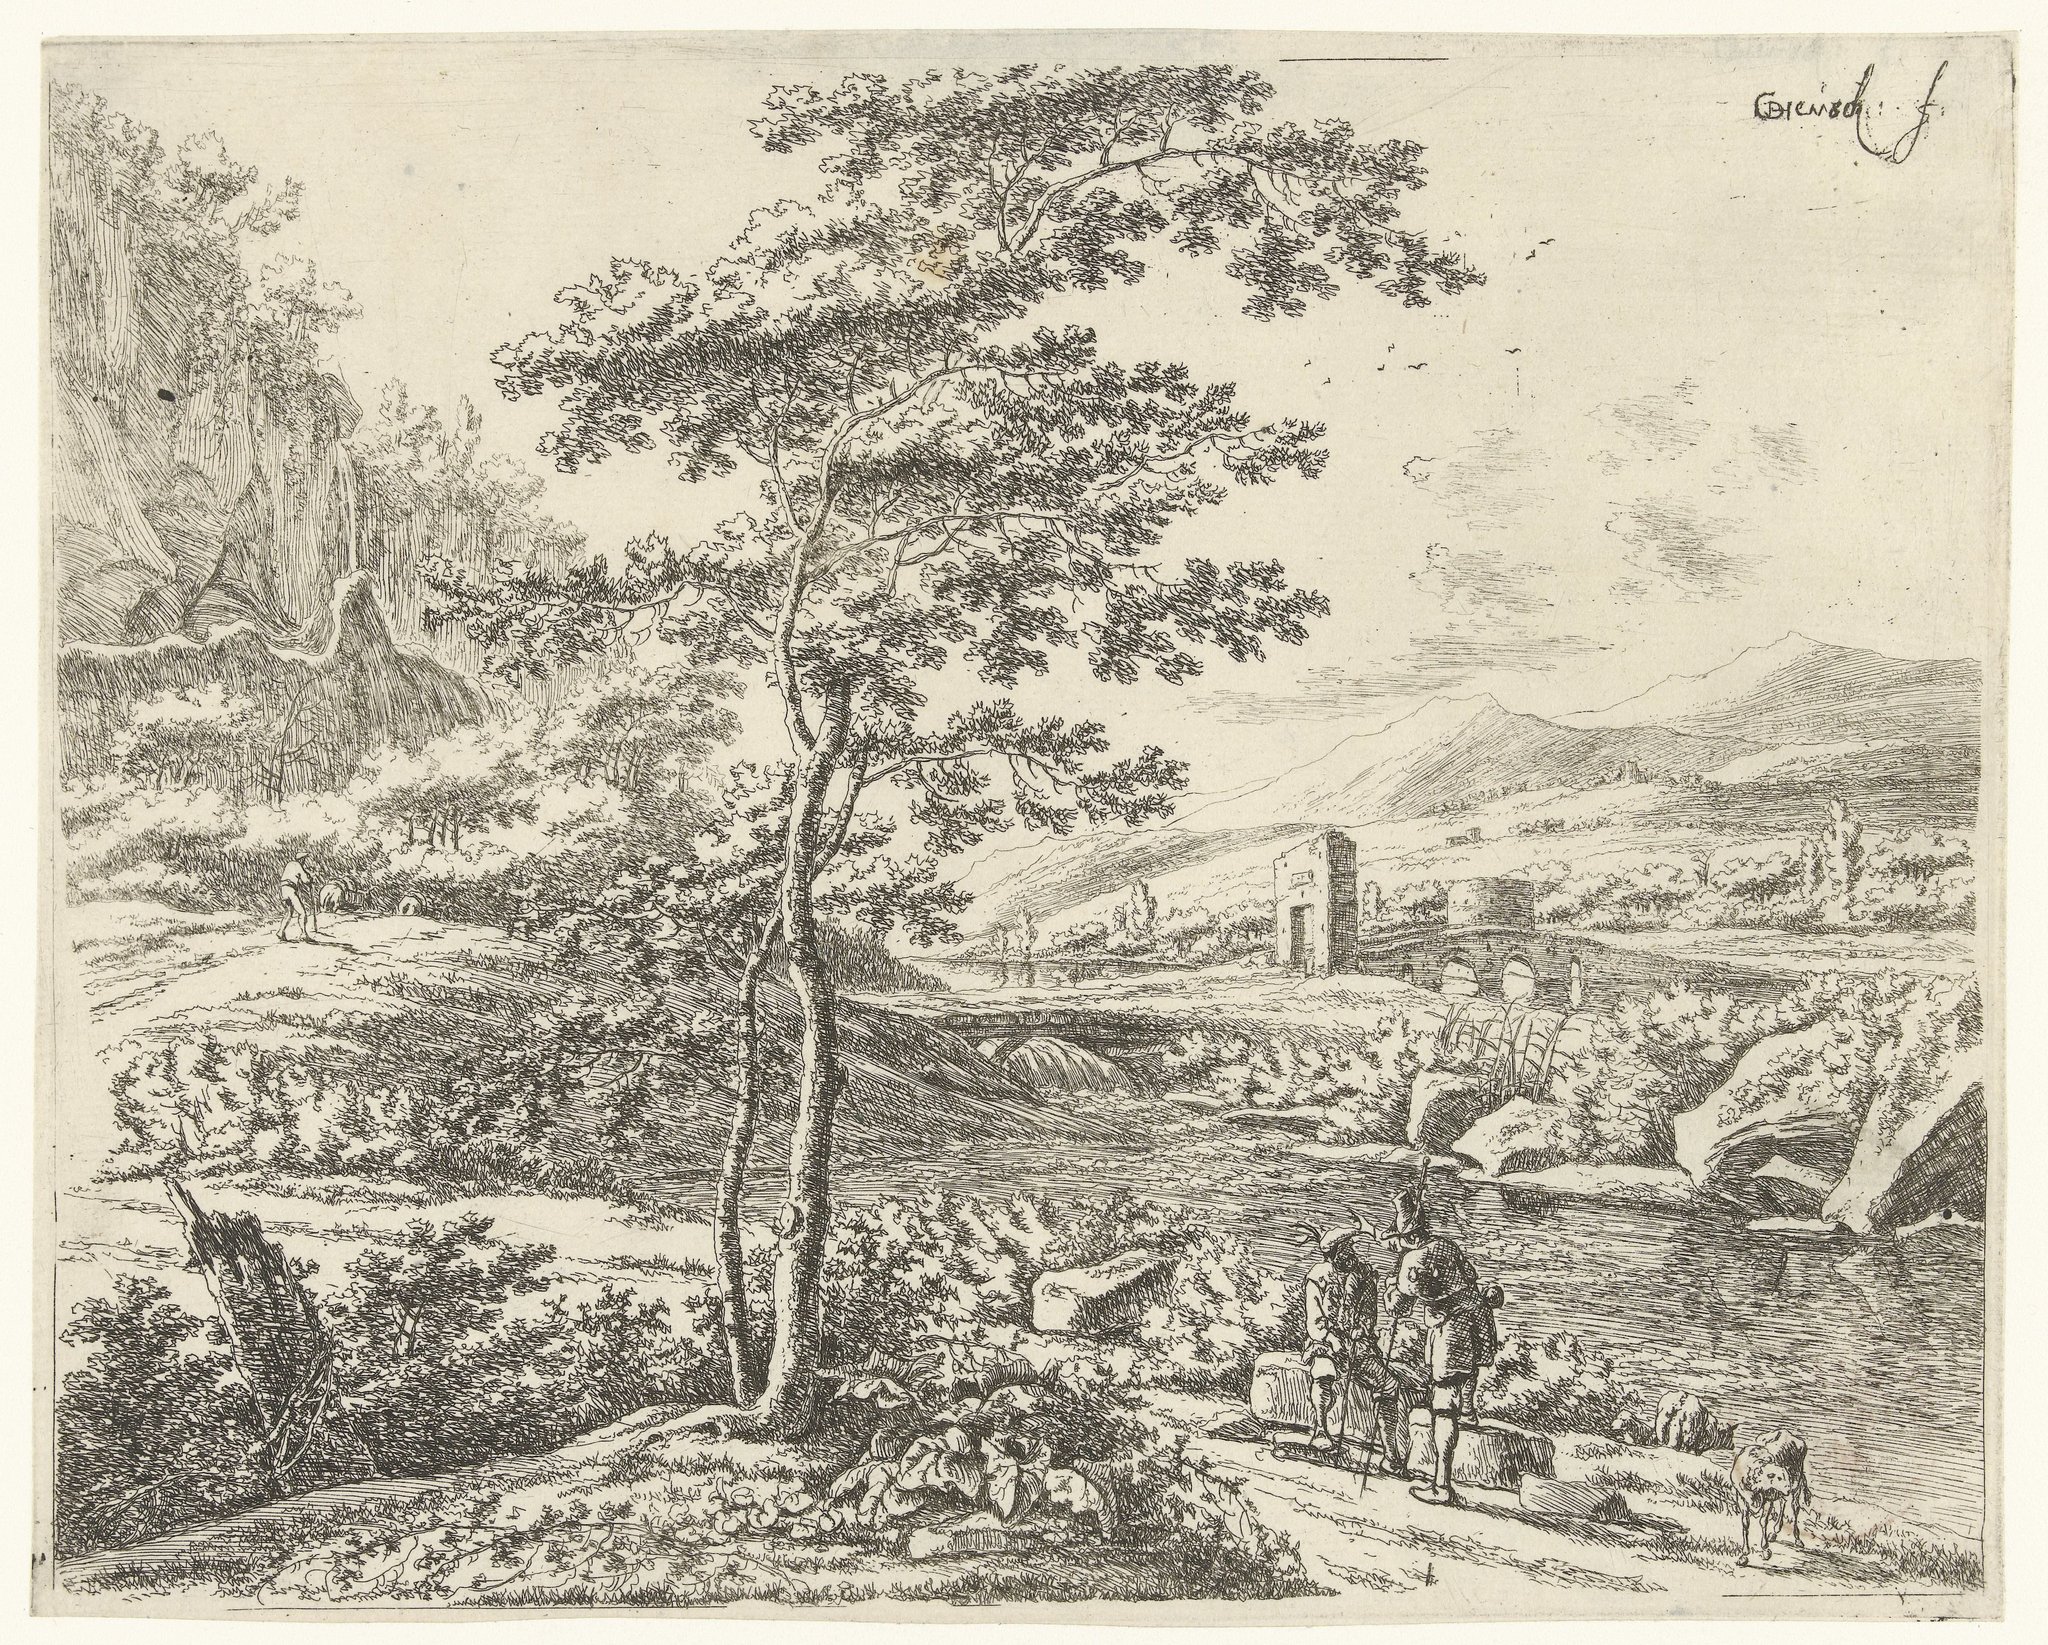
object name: print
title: Landschappen met figuren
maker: willem de heusch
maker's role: draughtsman, painter, print maker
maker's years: 1625-1692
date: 1690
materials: paper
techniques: etching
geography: utrecht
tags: herding, herdsman, herdswoman, shepherd, shepherdess, cowherd, etc., pilgrim(s), landscapes with waters, waterscapes, seascapes (in the temperate zone)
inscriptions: collector's mark: Lugt 240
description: Een pelgrim met een staf in zijn hand en jakobsschelpen op zijn mantel bij een zittende herder met schapen. Op de achtergrond een figuur met twee pakezels op een heuvel.